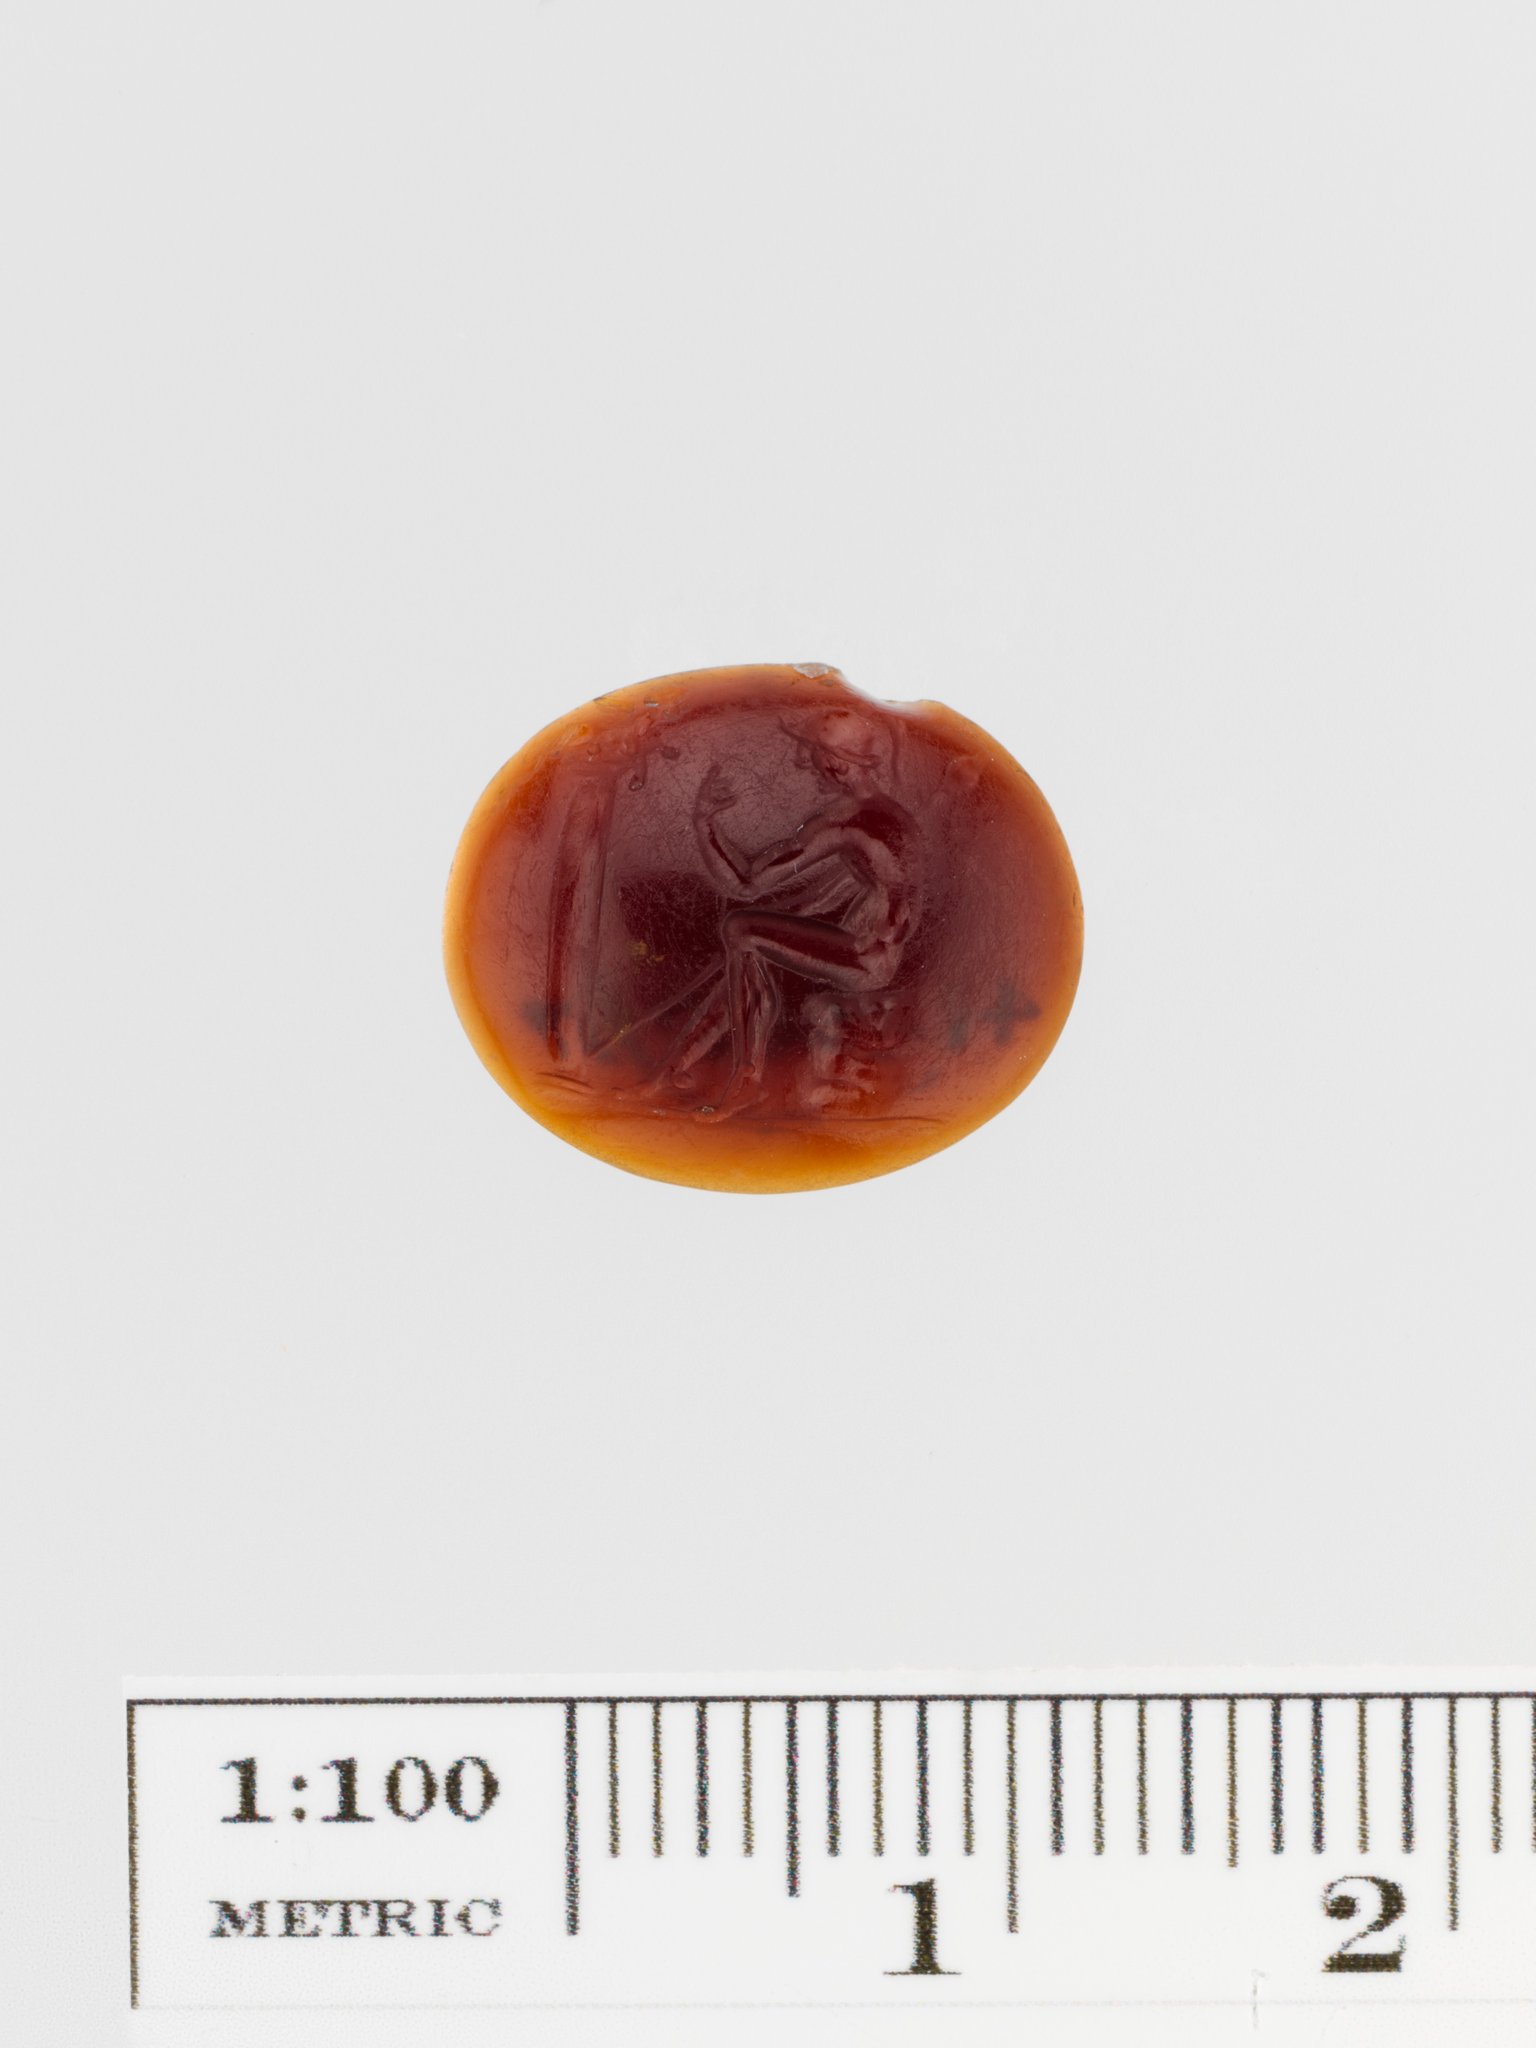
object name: intaglio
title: Sard ring stone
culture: roman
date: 1-100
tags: oedipus,sphinx